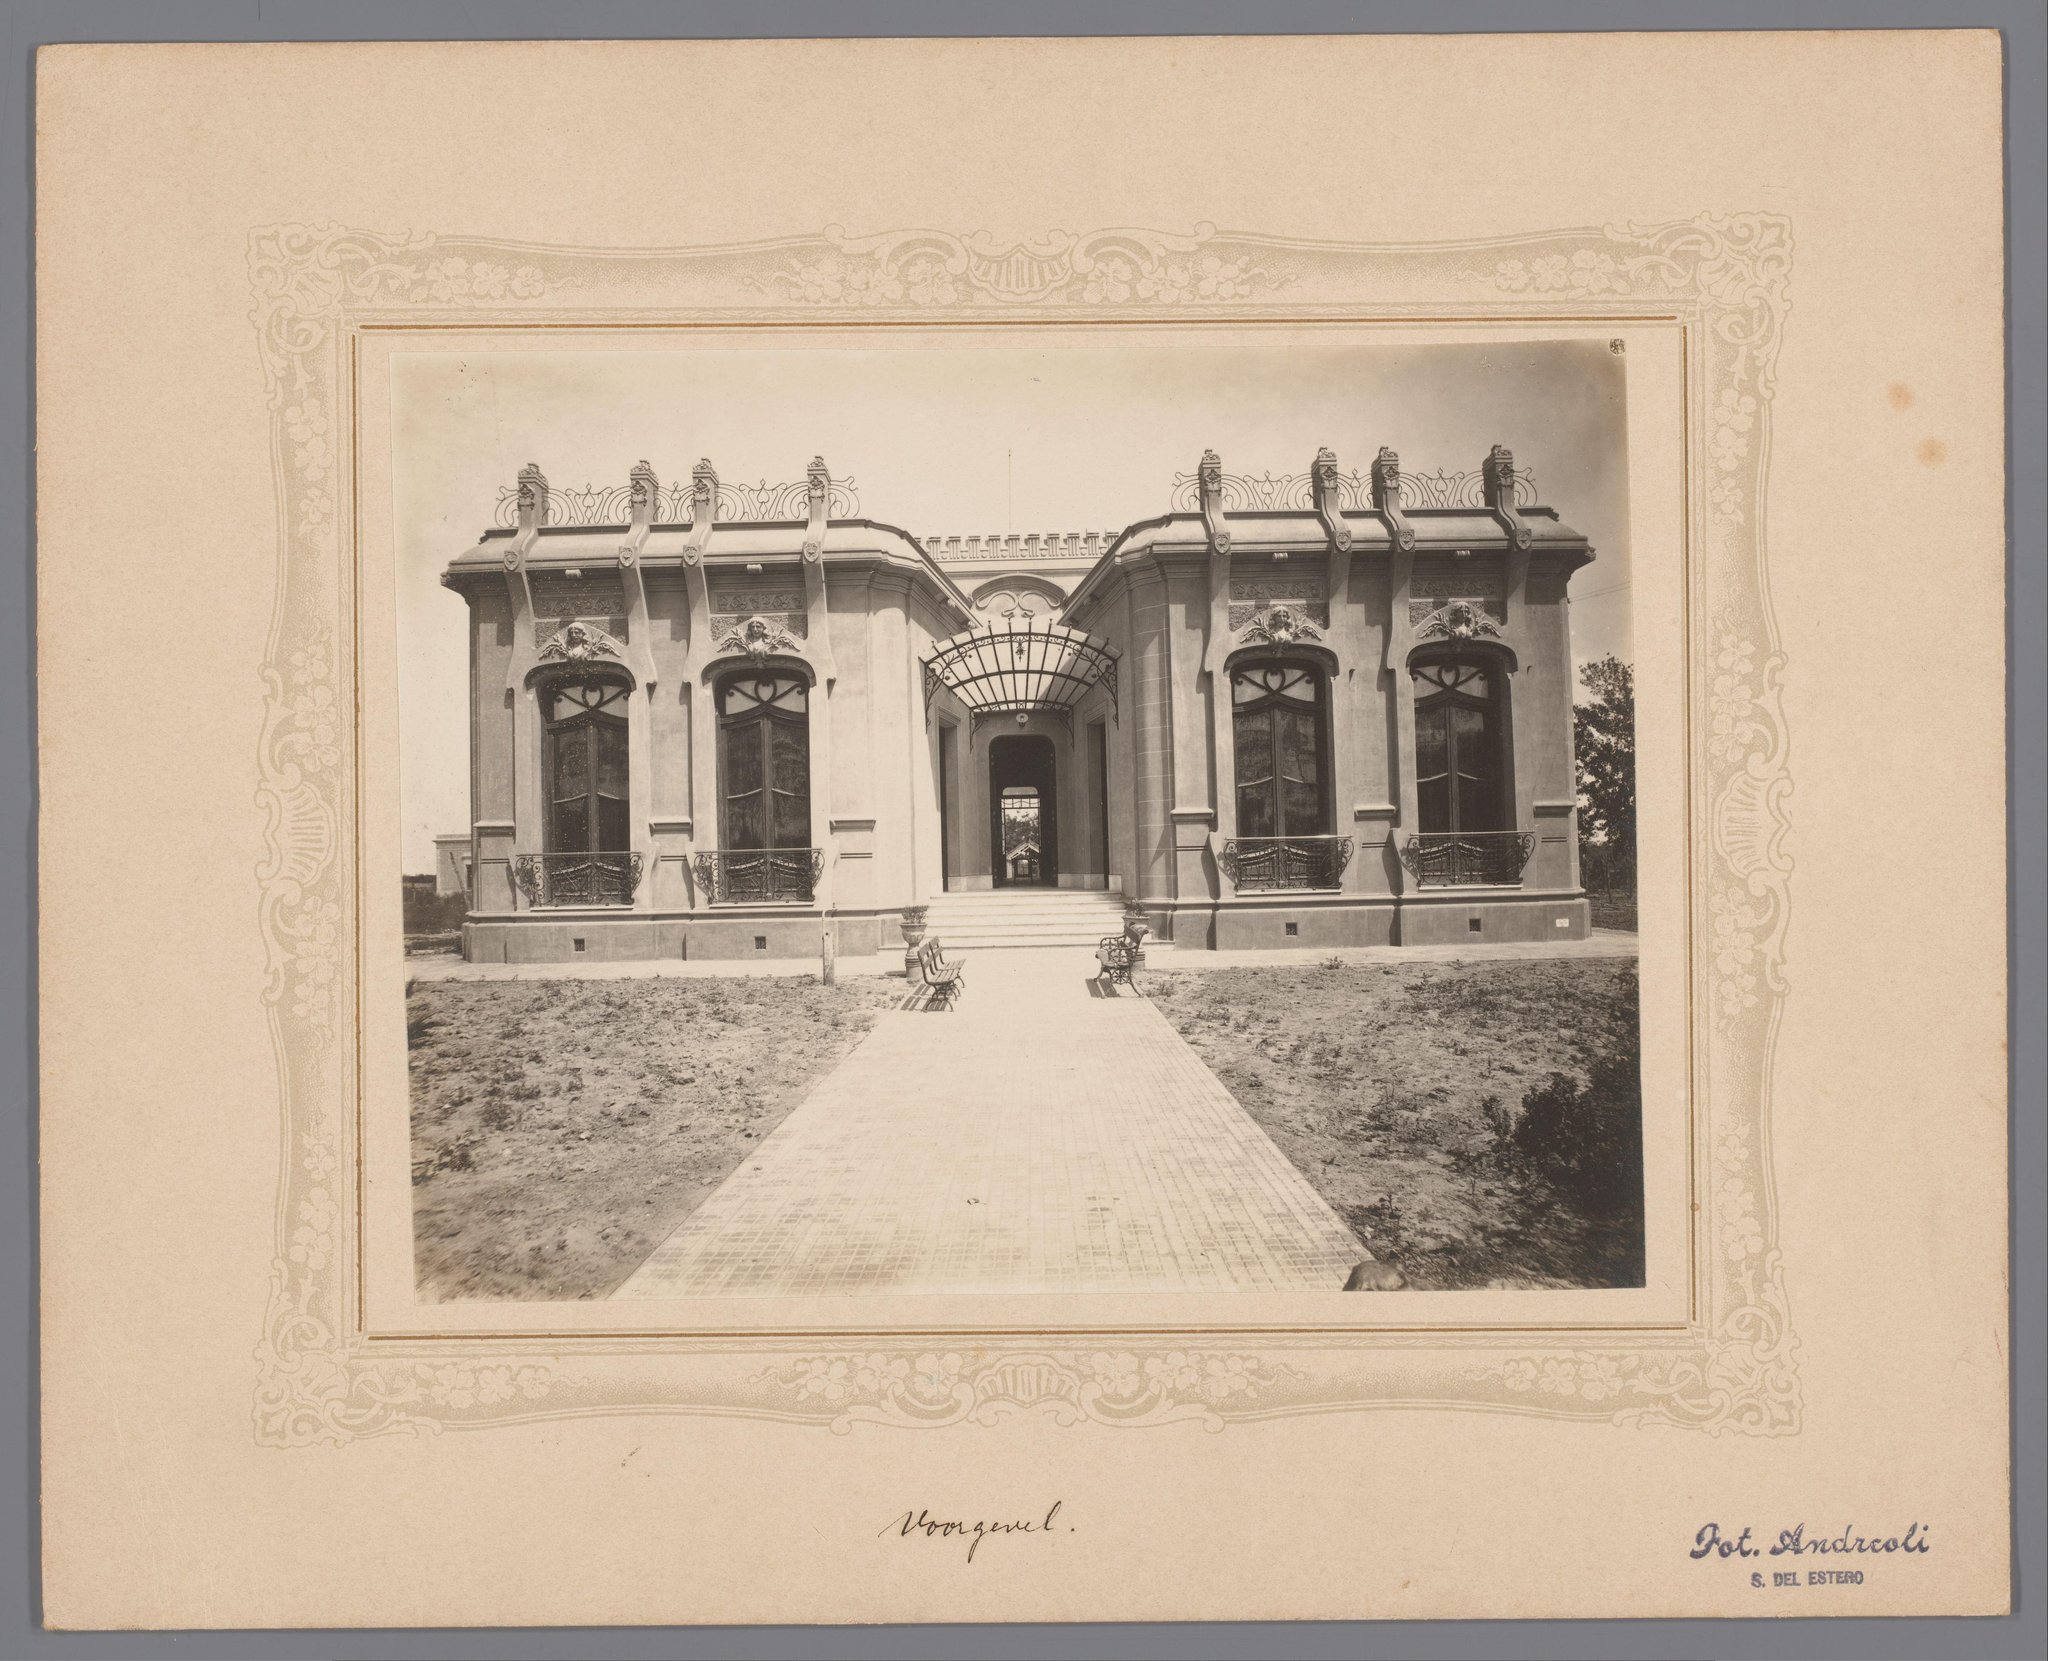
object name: photograph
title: Frontaal aanzicht op voorgevel van huis, Italië [?]/Spanje [?]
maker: andreoli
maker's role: fotograaf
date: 1880-1910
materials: cardboard, photographic support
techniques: gelatin silver print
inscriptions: caption: ‘Voorgevel.’, inscription: ‘=- 1890’, number: ‘5.’, stamp: ‘Pot. Andreoli//S. DEL ESTERO’